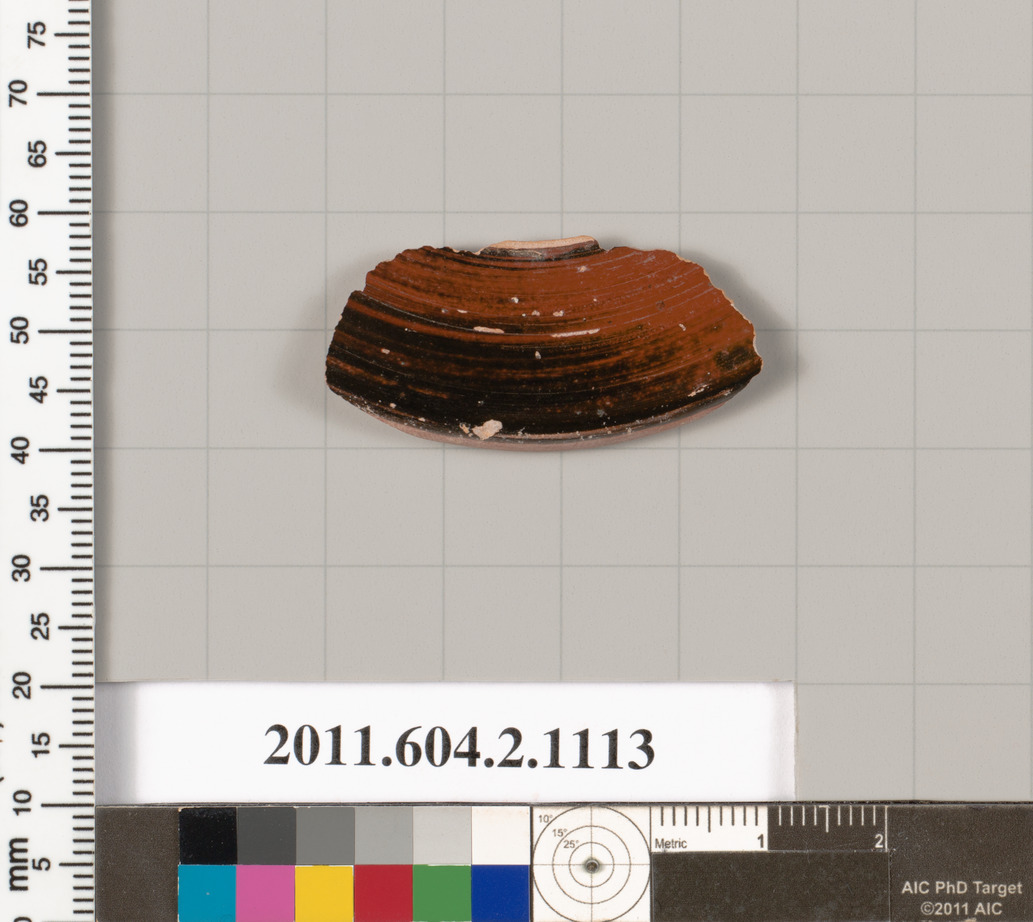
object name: lekythos fragment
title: Terracotta fragment of a lekythos (oil flask)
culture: greek, attic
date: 475-451 BCE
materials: terracotta